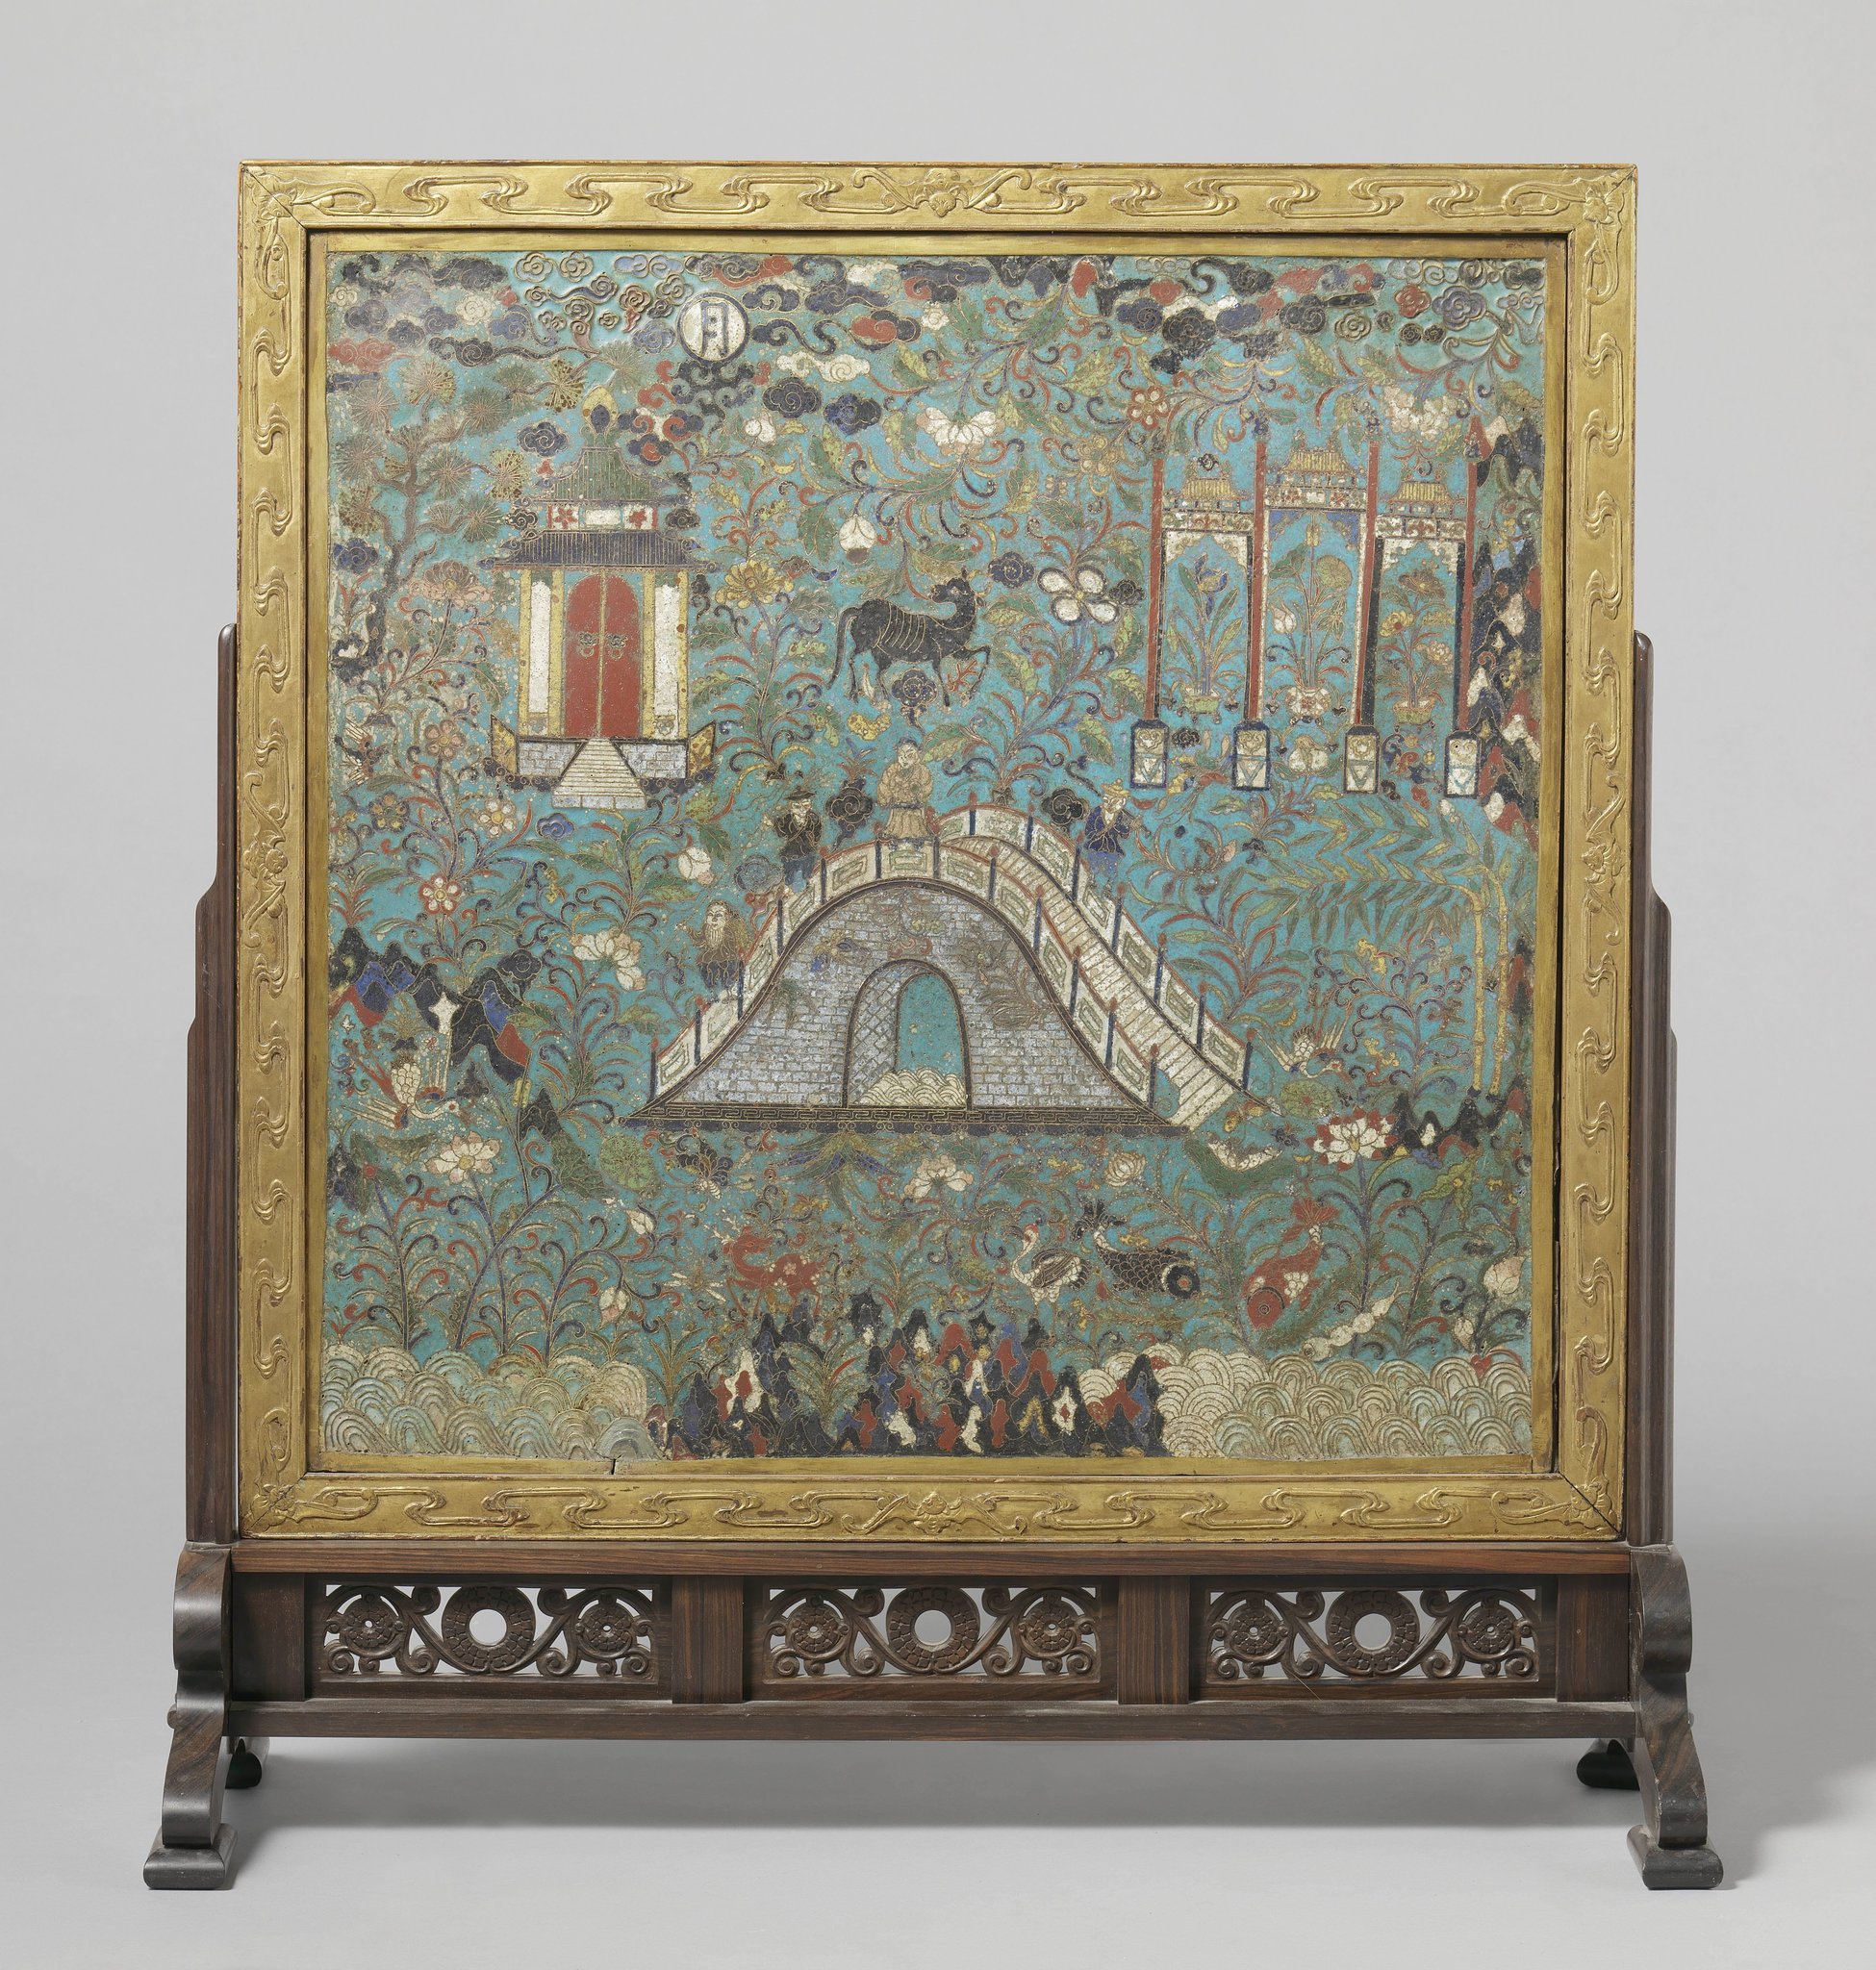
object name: houder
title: Panel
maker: Anonymous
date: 1700-1800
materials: wood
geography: china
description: This panel may depict Emperor Ming Huang (712–742) on his quest to achieve immortality. One of his magicians changed a bamboo cane into a bridge to the moon, where the emperor hoped to find the elixir of life. The panel was originally made to decorate a wall. One of its owners later turned it into a fire screen.